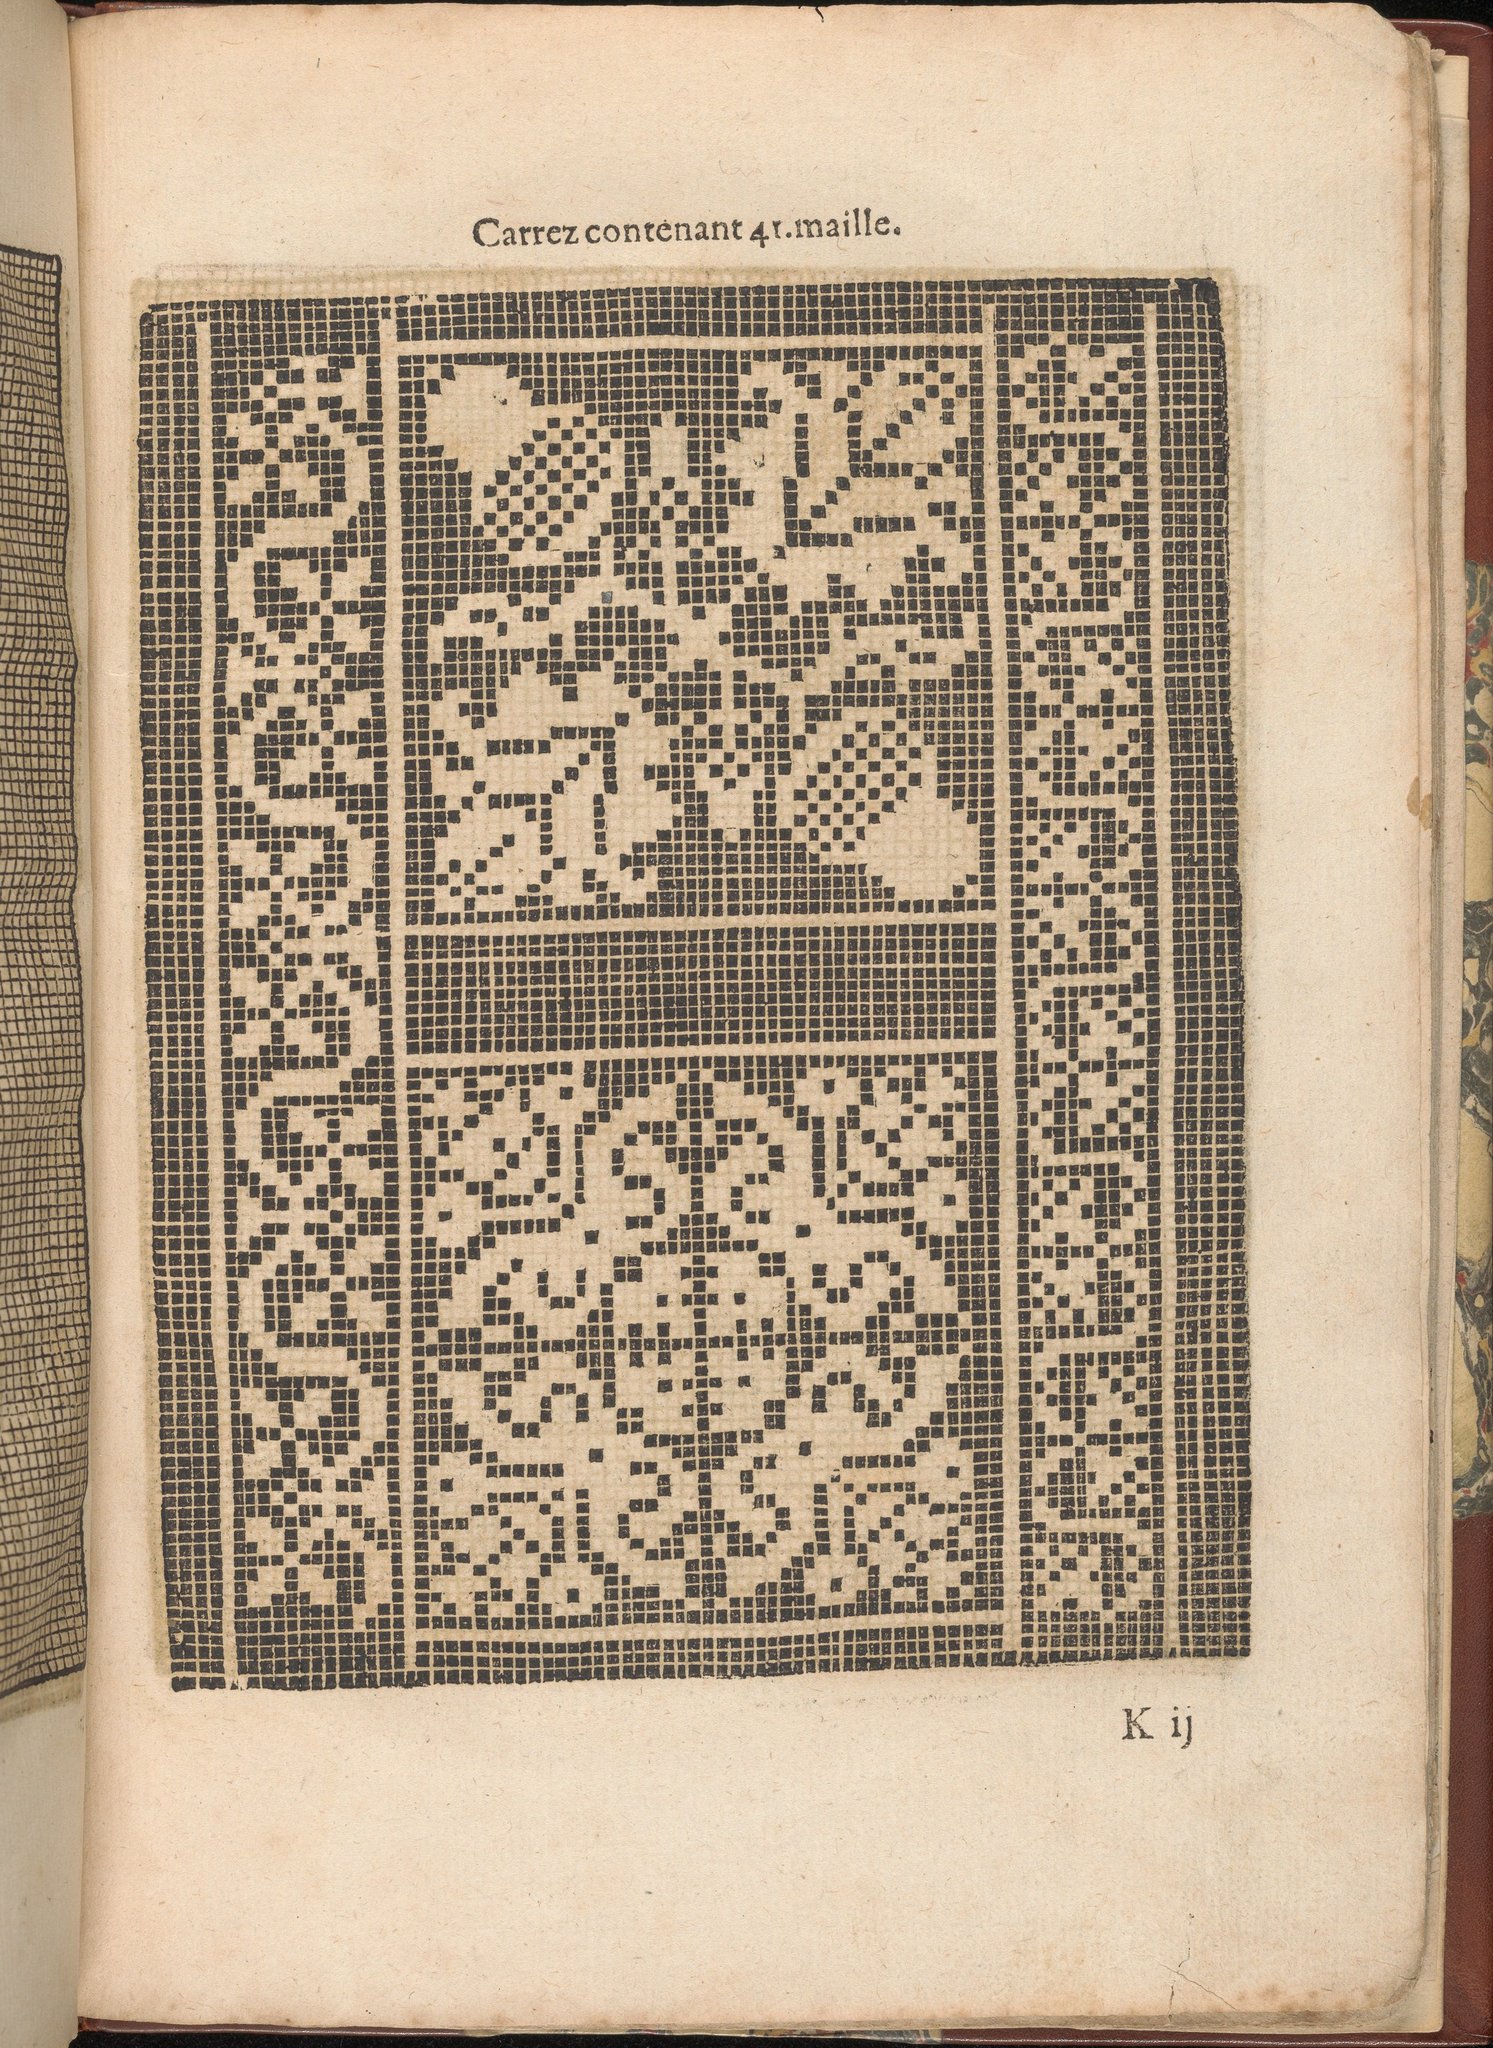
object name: book print ornament architecture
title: Les Secondes Oeuvres, et Subtiles Inventions De Lingerie du Seigneur Federic de Vinciolo Venitien, page 38 (recto)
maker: federico de vinciolo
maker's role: designer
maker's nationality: italian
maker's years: 1582-1599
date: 1603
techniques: woodcut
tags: ornament